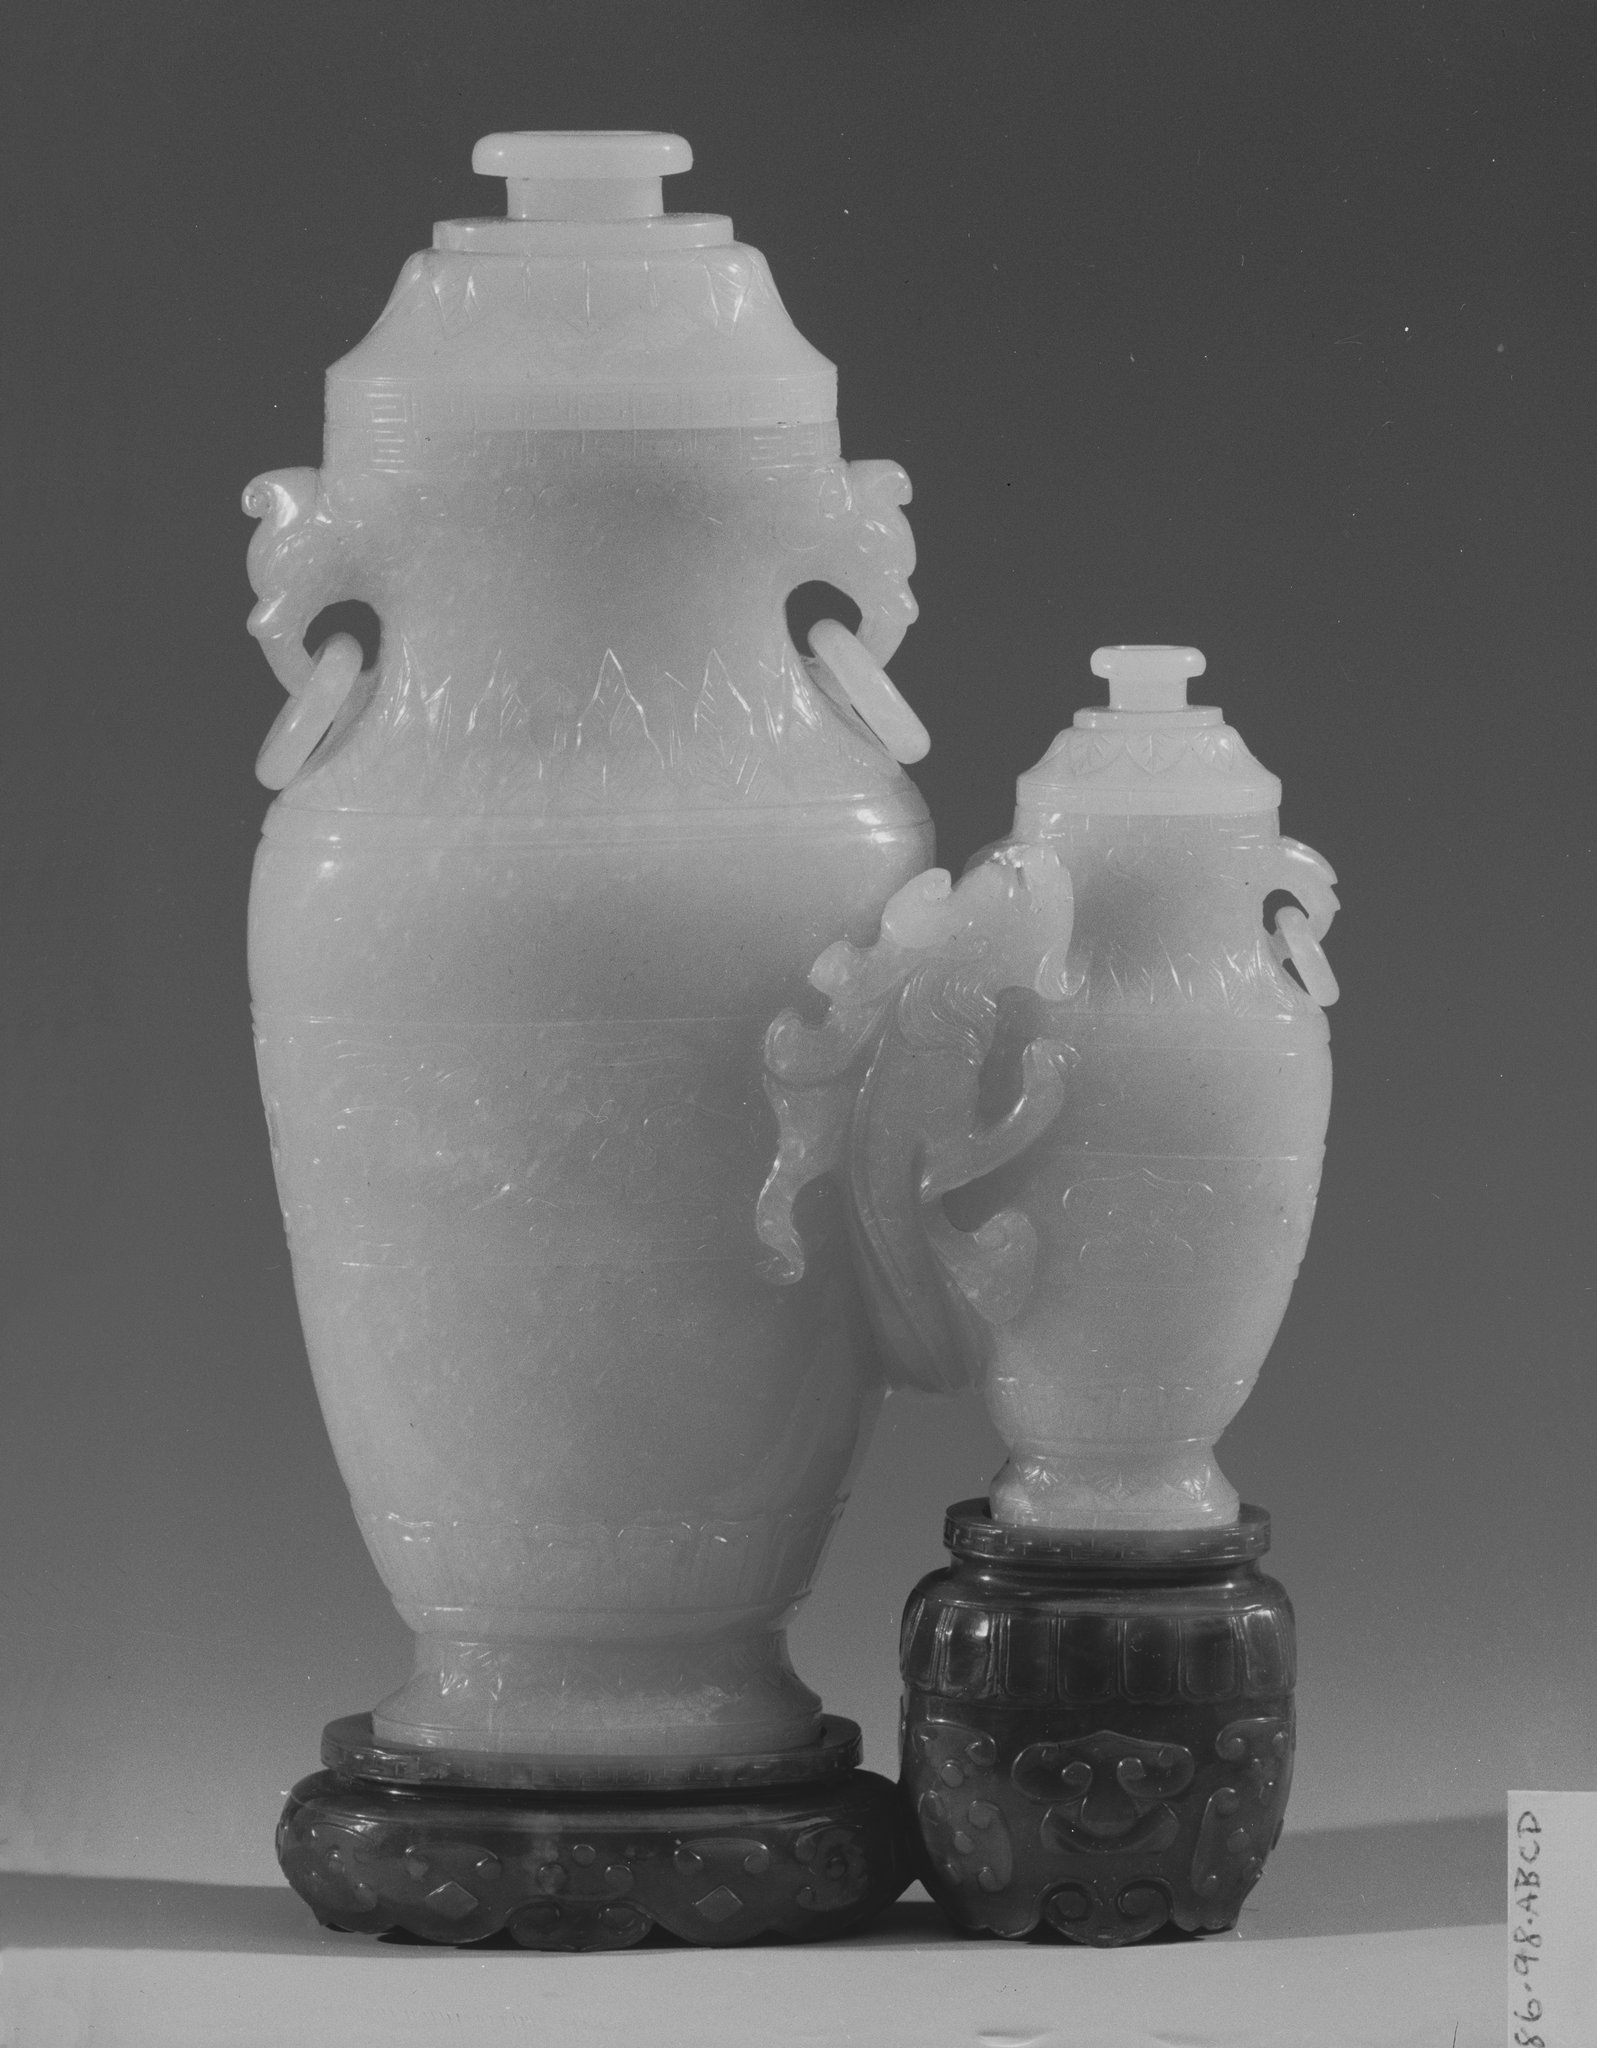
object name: vase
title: Twin Vases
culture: chinese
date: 1801-1900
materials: jade